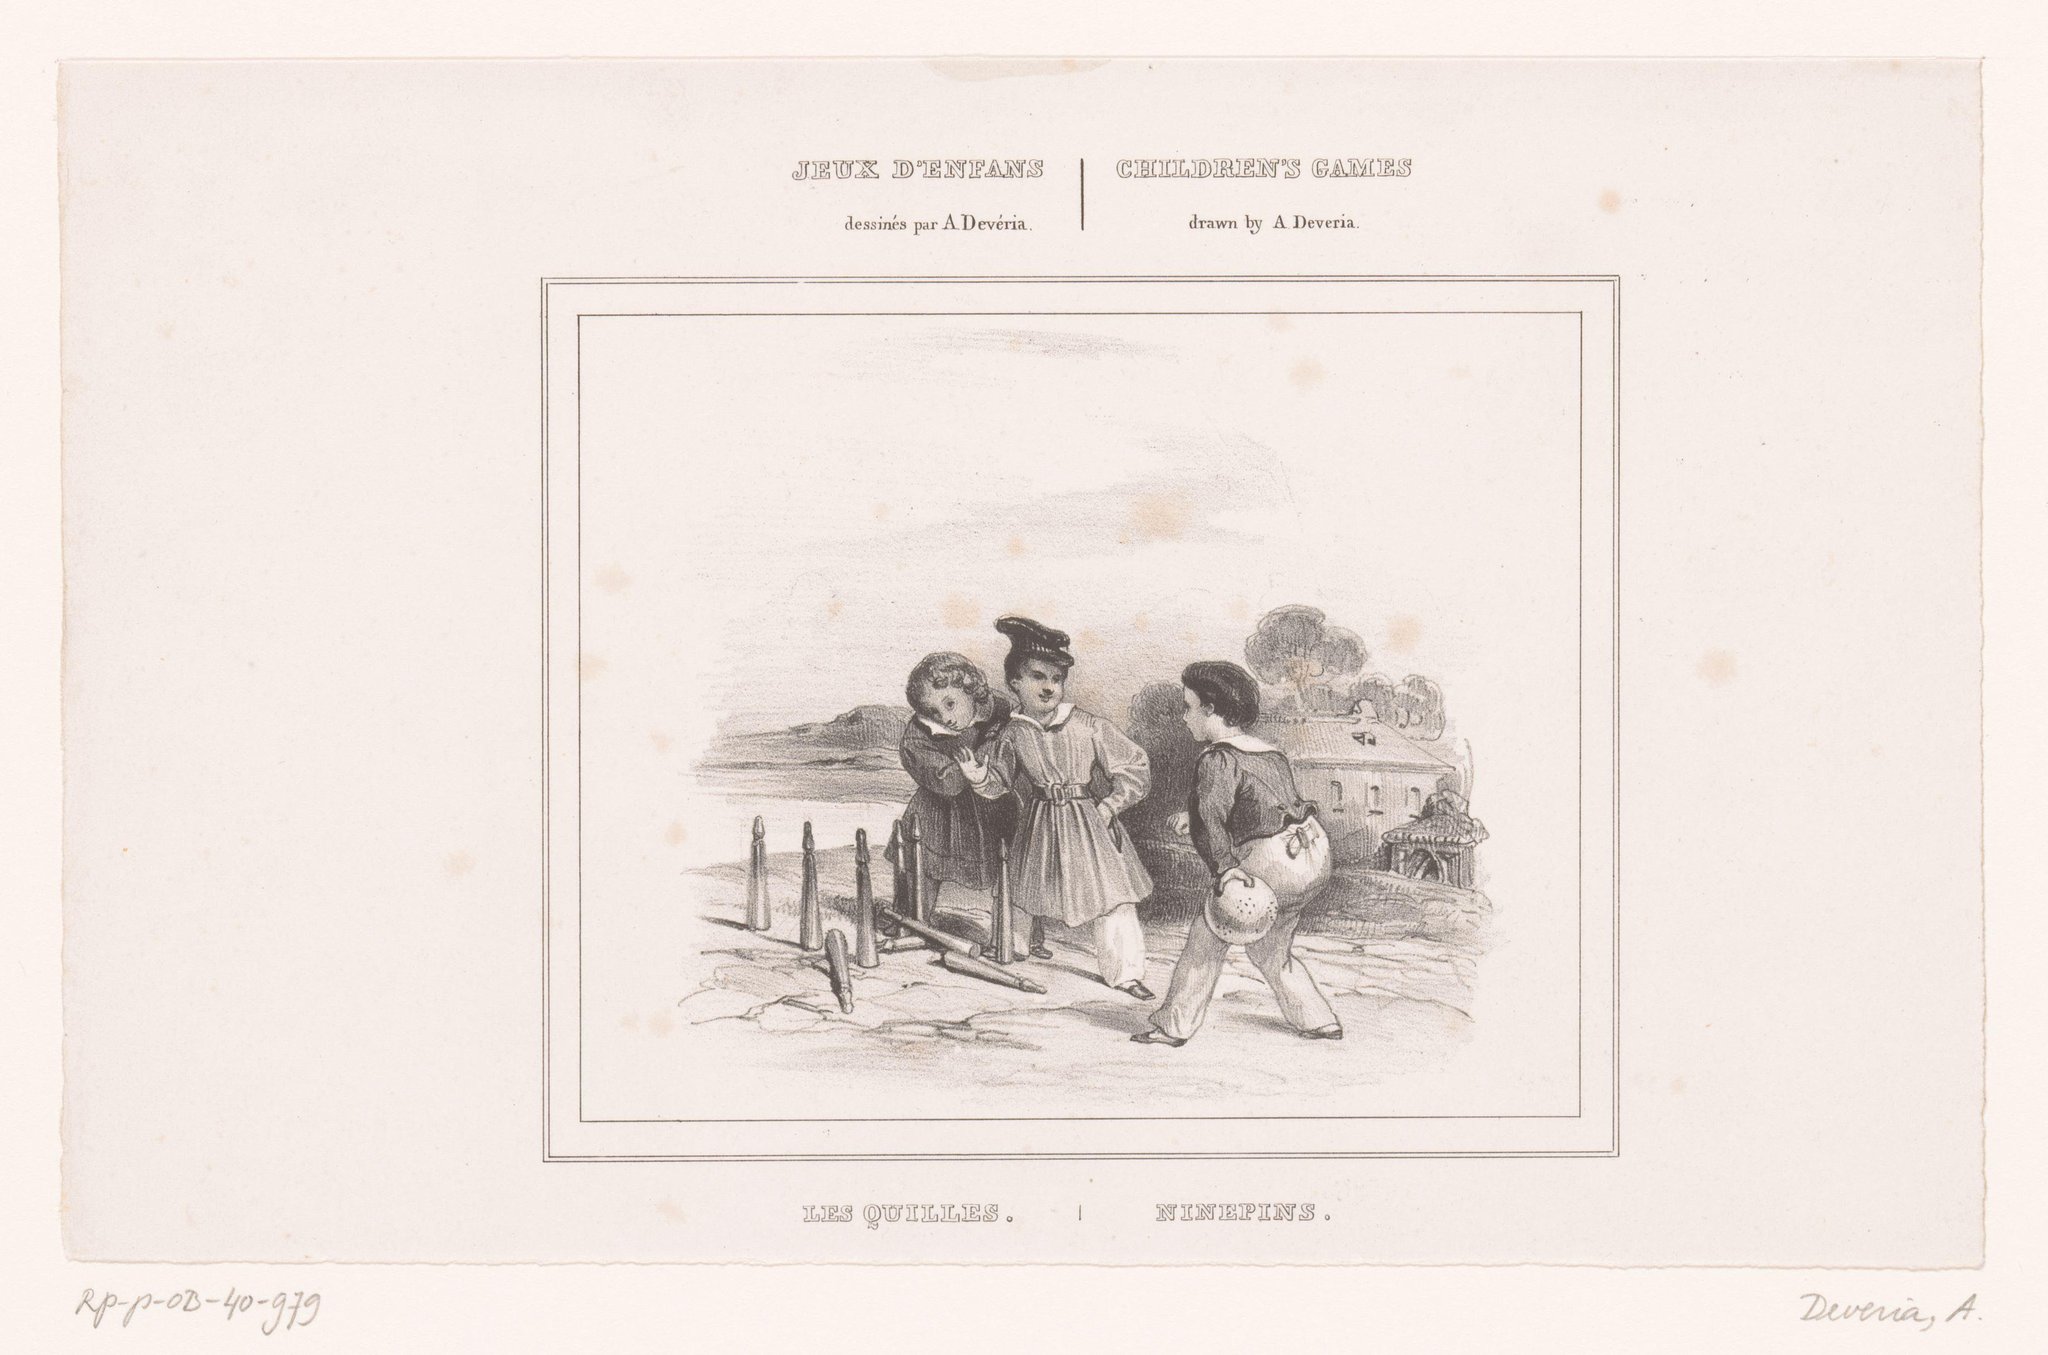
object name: print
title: Les quilles / Ninepins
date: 1832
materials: paper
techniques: lithograph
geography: paris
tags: child, games using special objects (marbles, top, hoop, etc.), ninepins, skittles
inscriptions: collector's mark: Lugt 2166